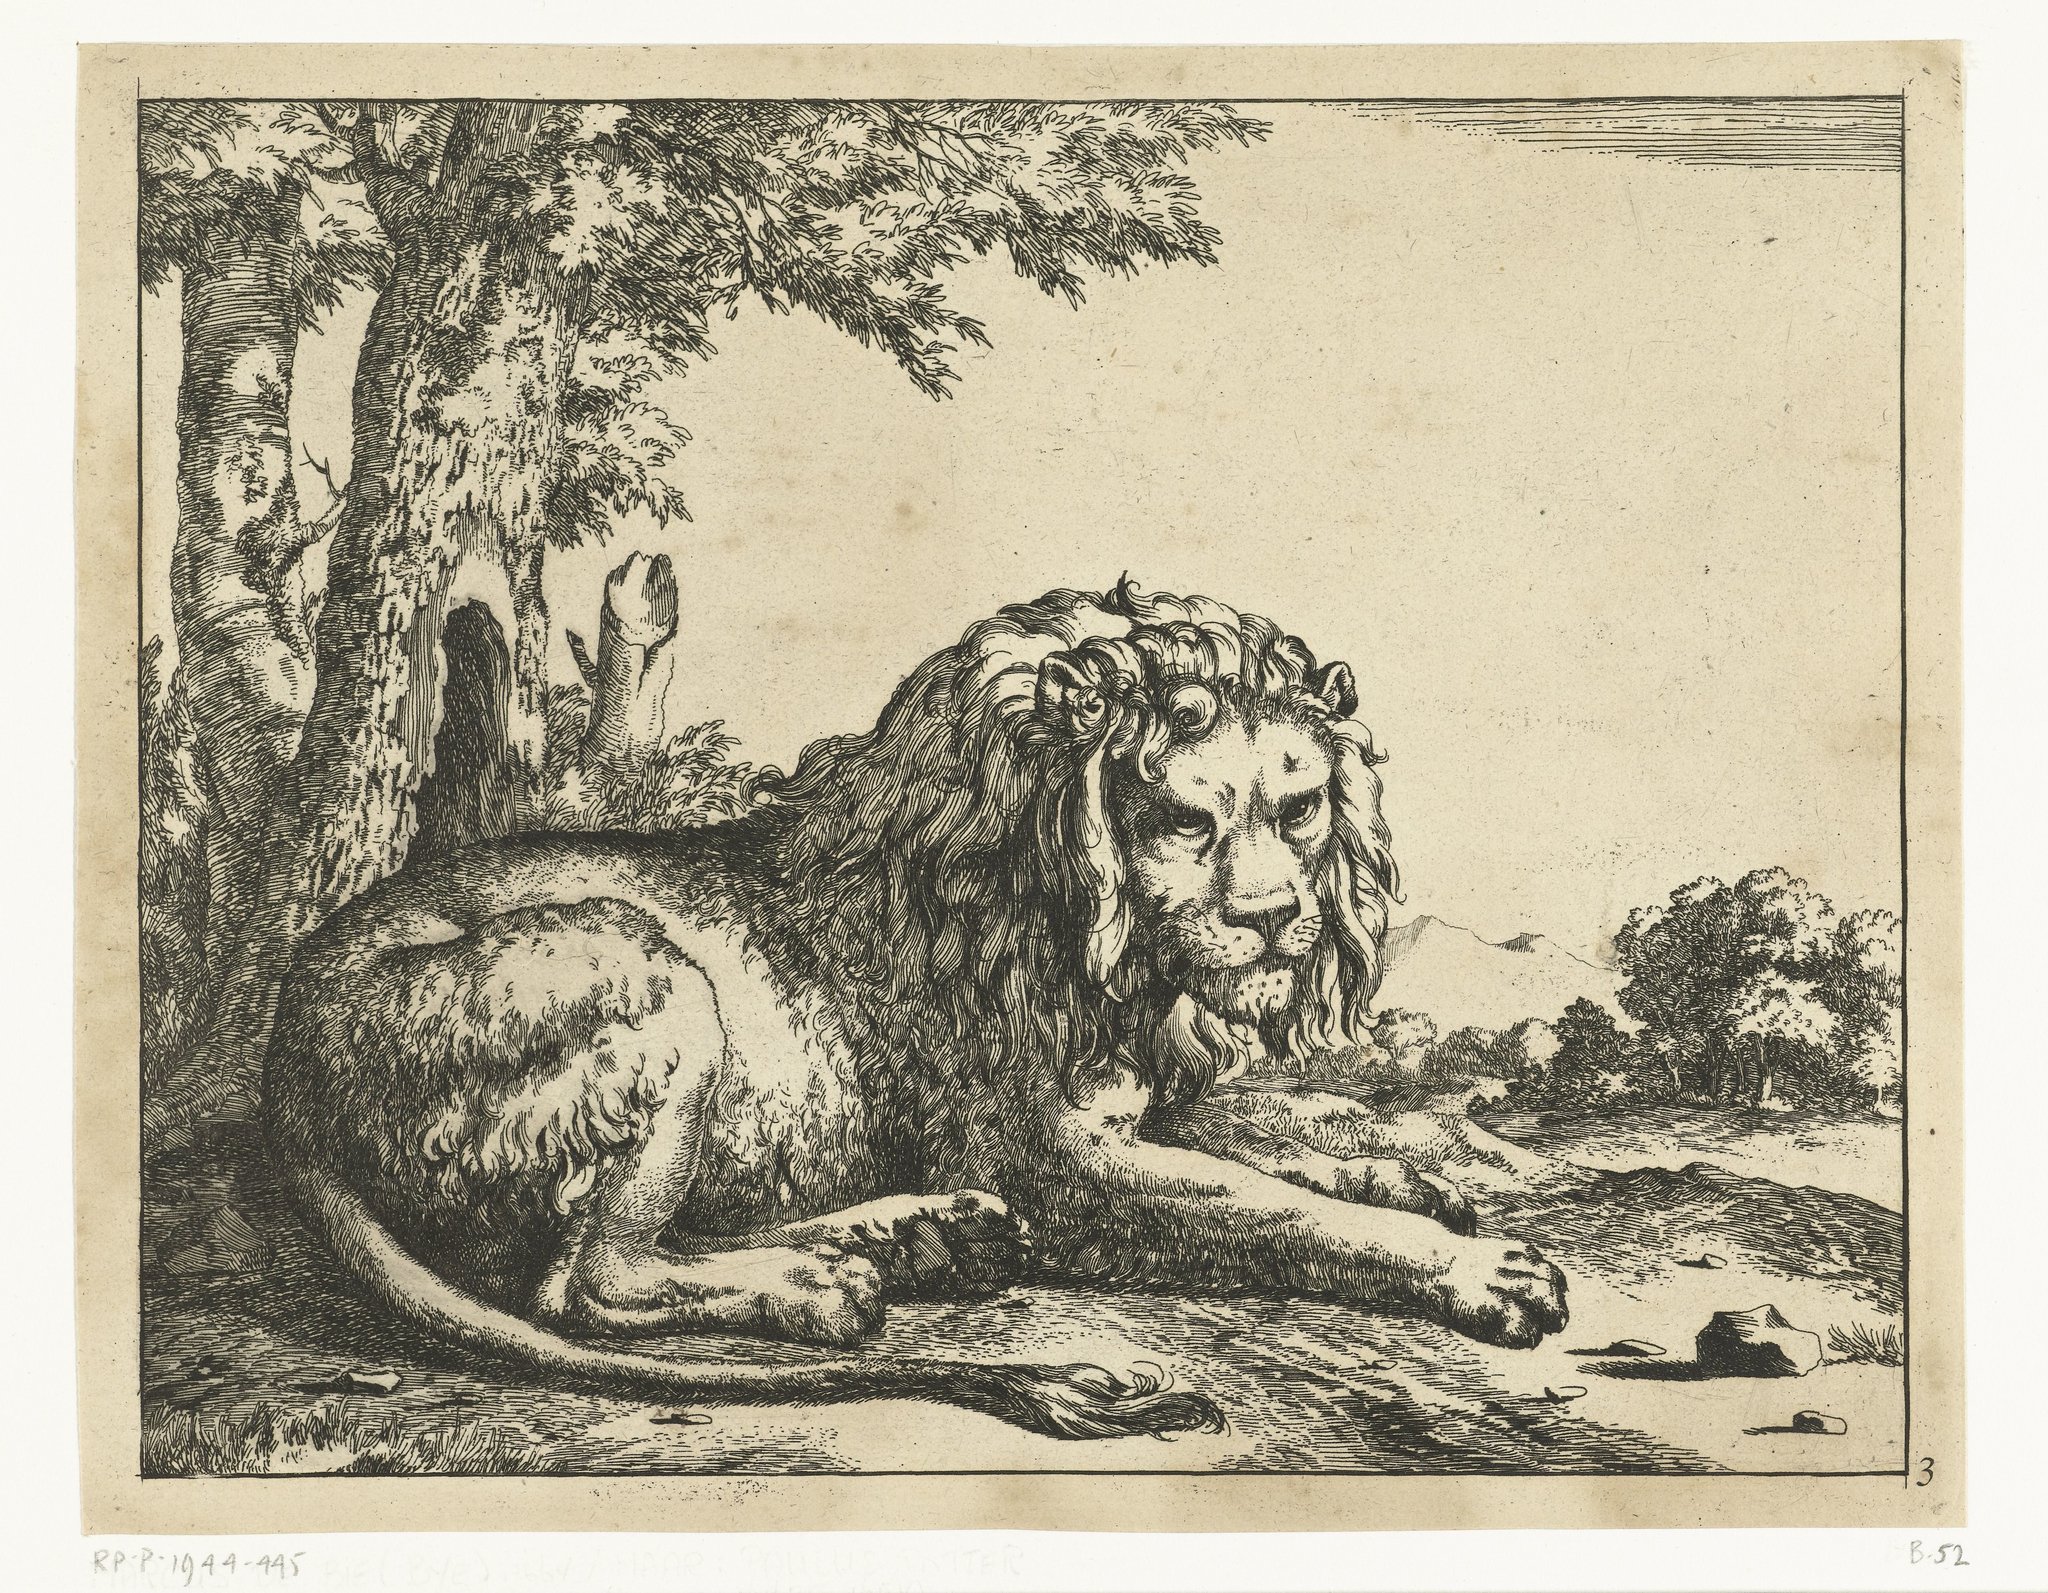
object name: print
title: Liggende leeuw de staart op de voorgrond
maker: marcus de bye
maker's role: print maker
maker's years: 1639-1688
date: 1664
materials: paper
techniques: etching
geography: the hague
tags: beasts of prey, predatory animals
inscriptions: collector's mark: Lugt 2228